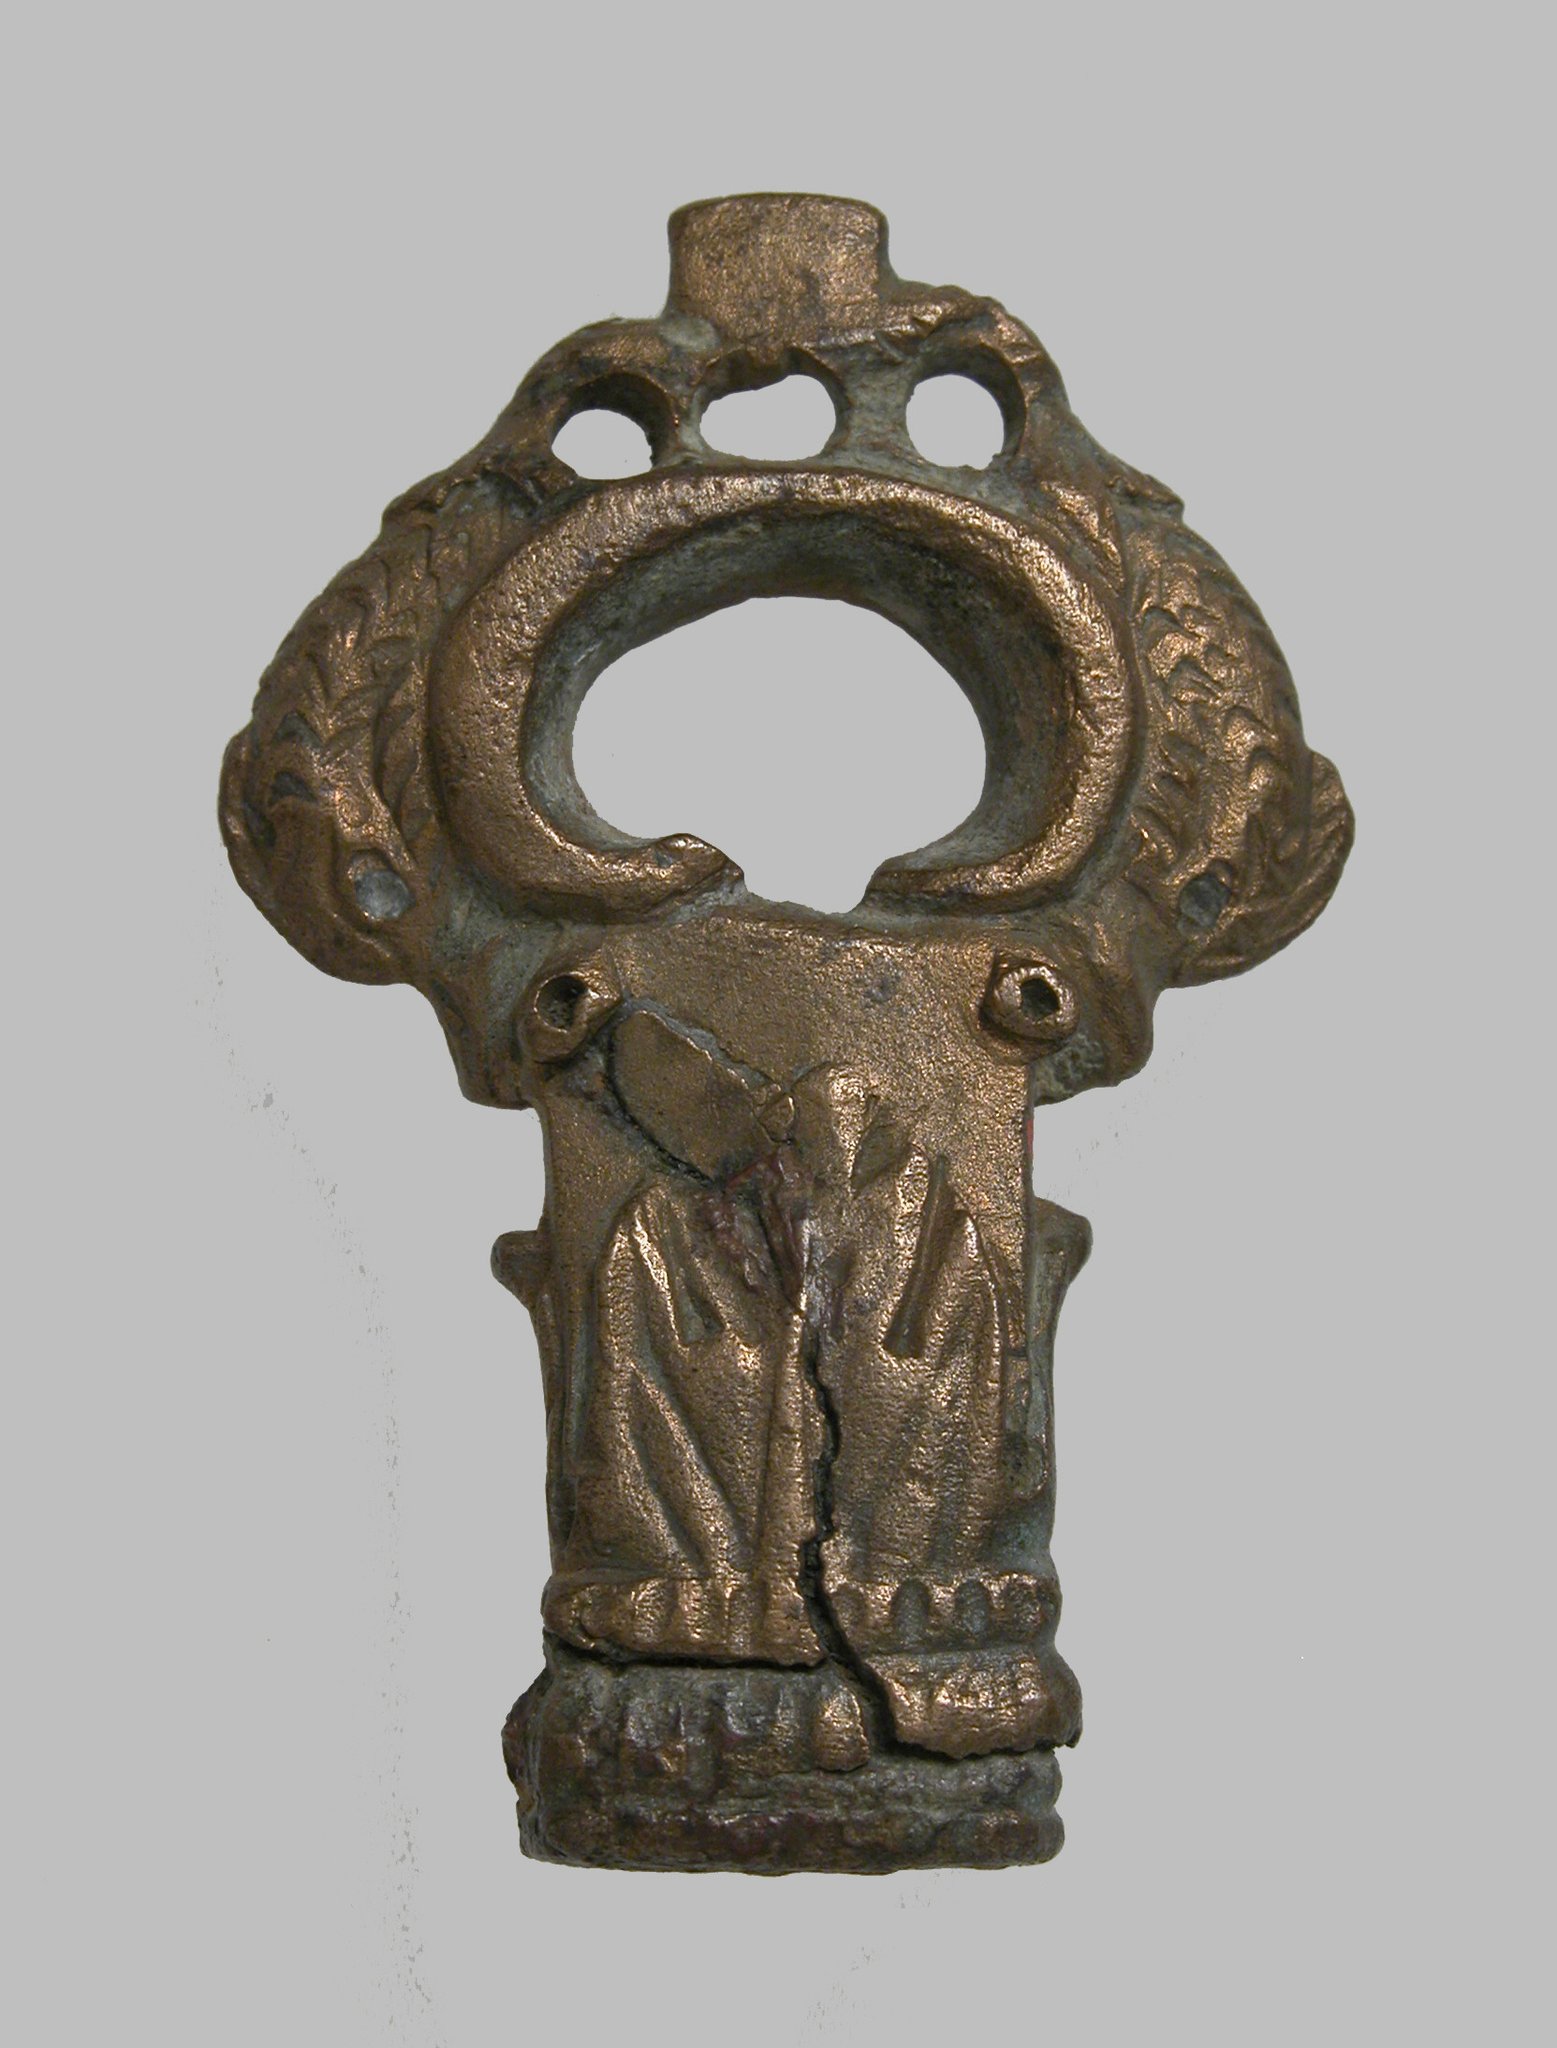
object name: key handle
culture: roman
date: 1-700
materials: copper alloy